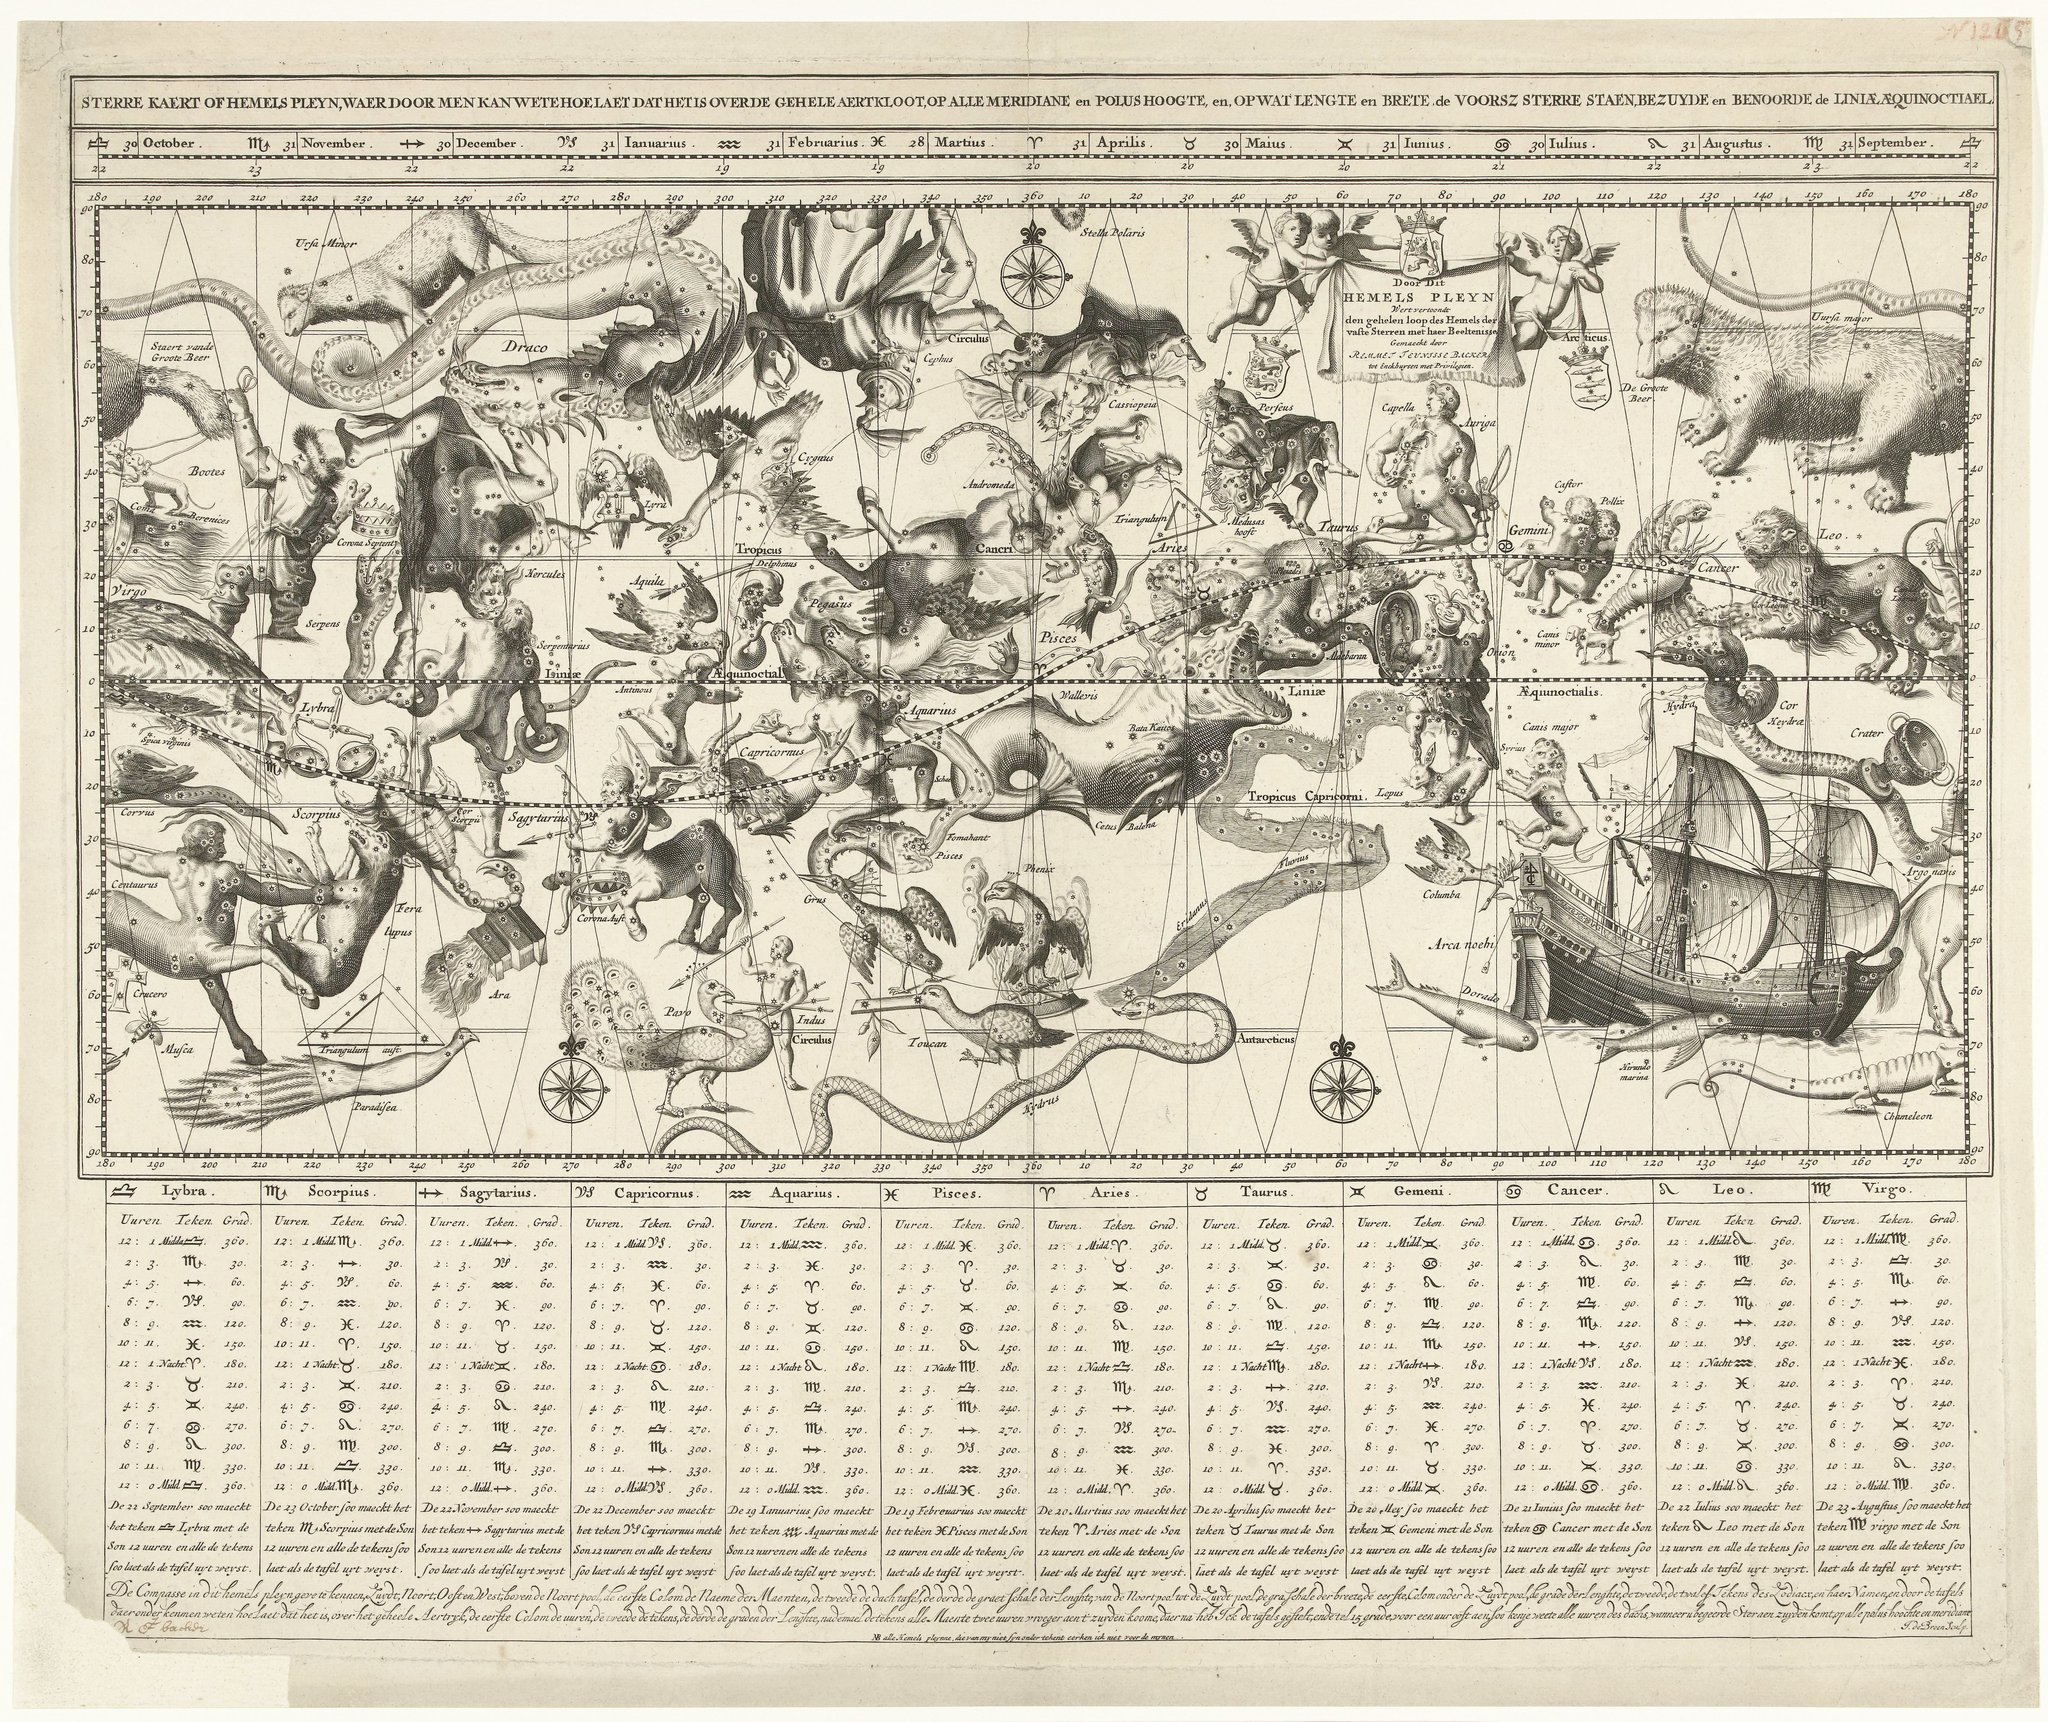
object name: astronomical chart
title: Hemelskaart voor de noordelijke en zuidelijke sterrenhemel uitgevoerd in Mercatorprojectie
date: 1684-1709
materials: paper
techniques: engraving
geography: amsterdam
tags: star-chart, star map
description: Voor het eerst gebruikt in: Gerard van Keulen, De groote nieuwe vermeerderde zee-atlas ofte water-waereld . Amsterdam: Johannes van Keulen, 1709.